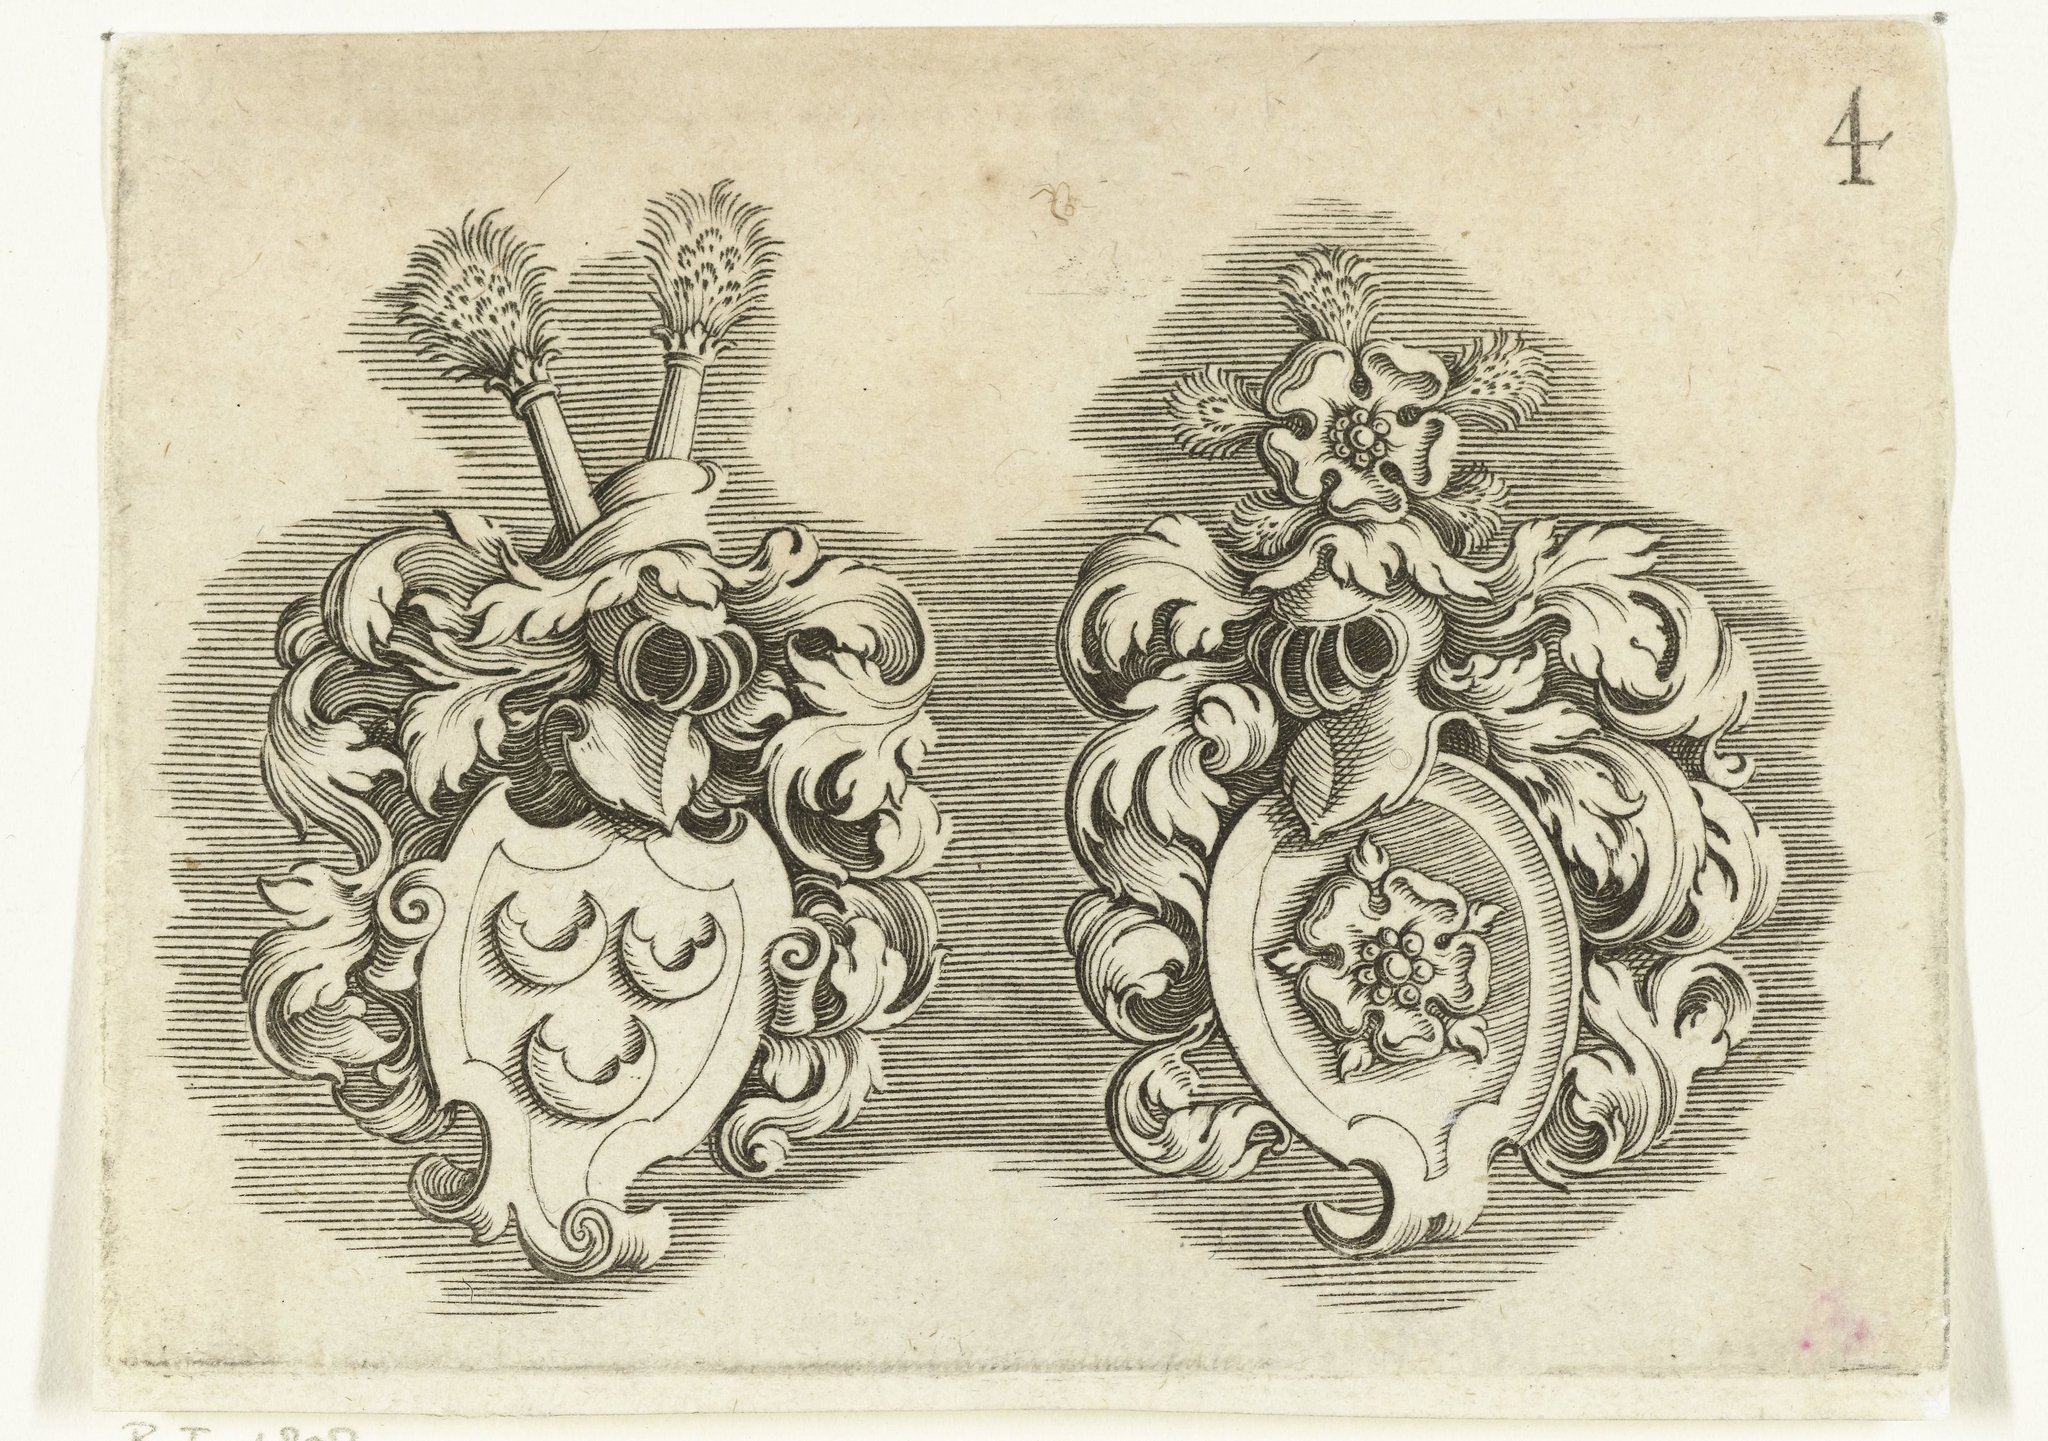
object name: ornament print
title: Twee wapenschilden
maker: Anonymous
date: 1611-1625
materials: paper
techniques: engraving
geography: amsterdam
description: Links de 'principauté d'Engern', rechts de "burgraviat d' Altenburg'.